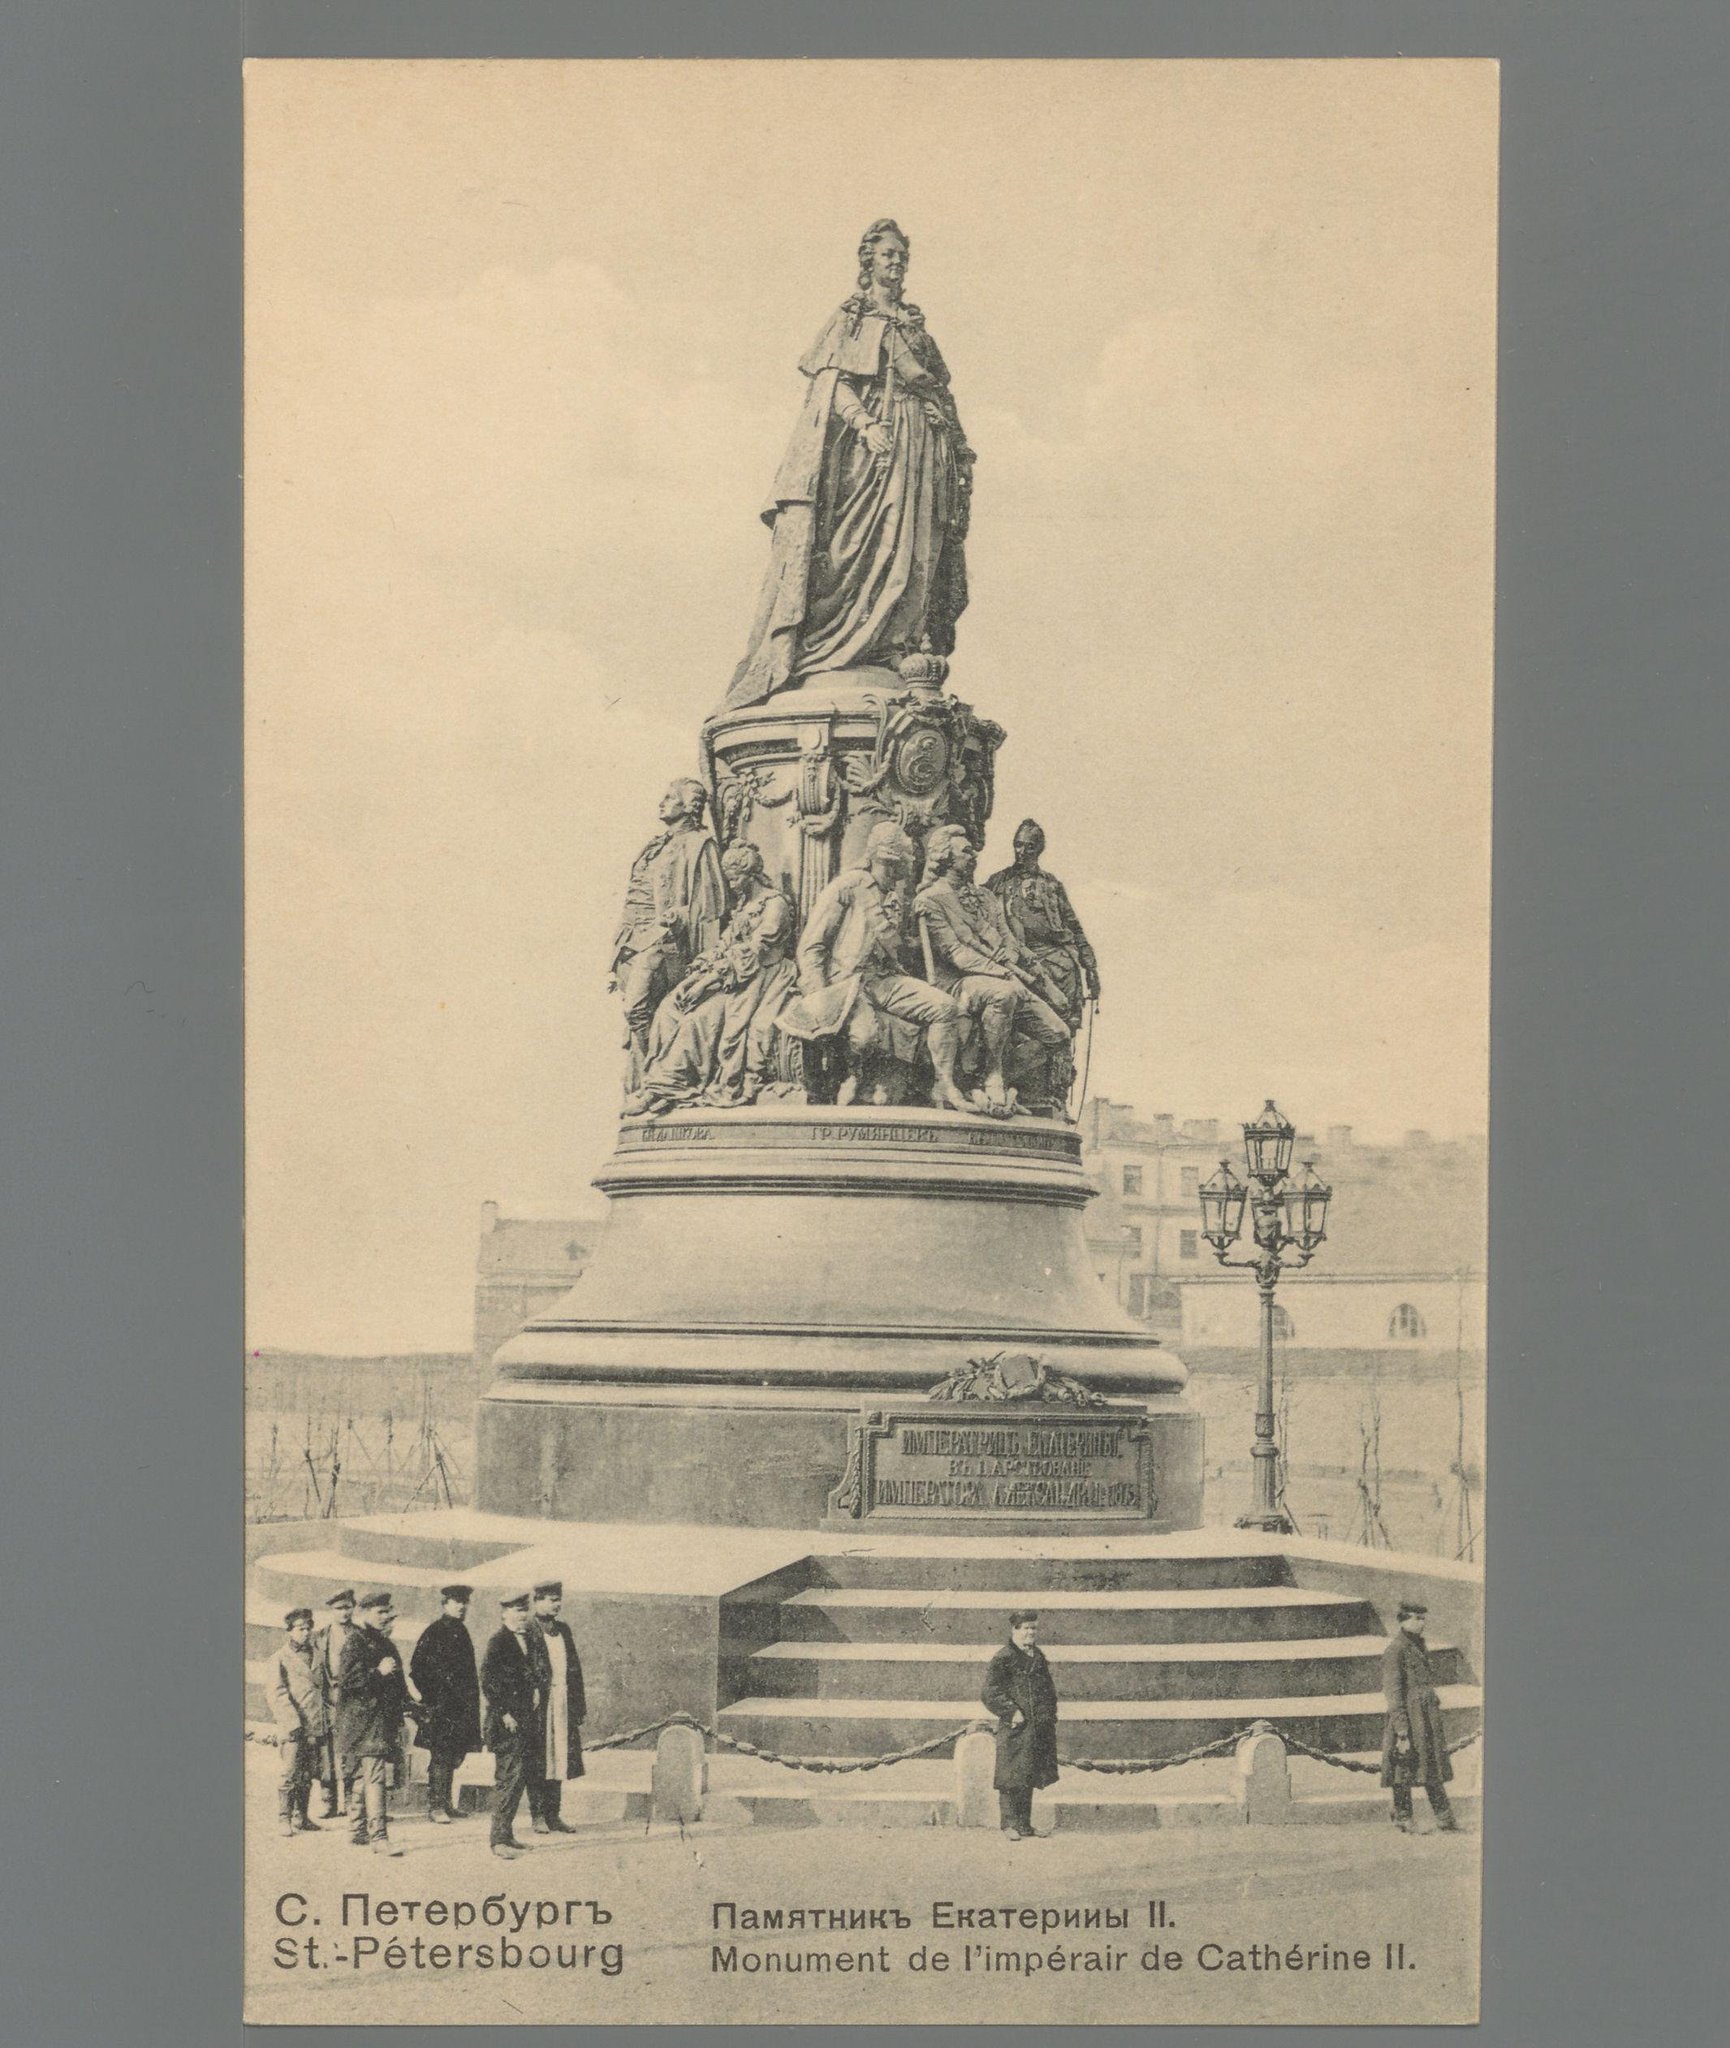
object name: photomechanical print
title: St.-Pétersbourg. Monument de l'impérair de Cathérine II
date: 1904-1930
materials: cardboard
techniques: photograph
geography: sint-petersburg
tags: catharina de grote, monument, statue, emperor - bb - female ruler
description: Boven de Franse titel staat de titel in het Russisch.